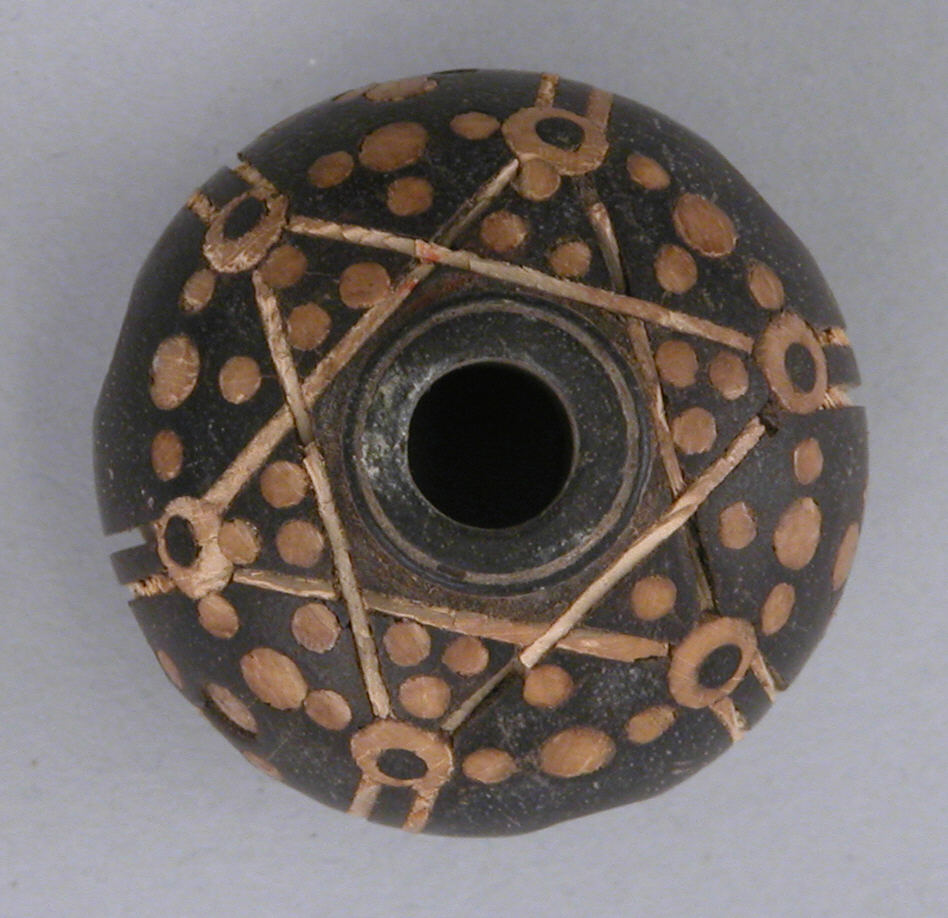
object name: bead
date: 201-700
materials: ivory, wood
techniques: inlay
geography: egypt